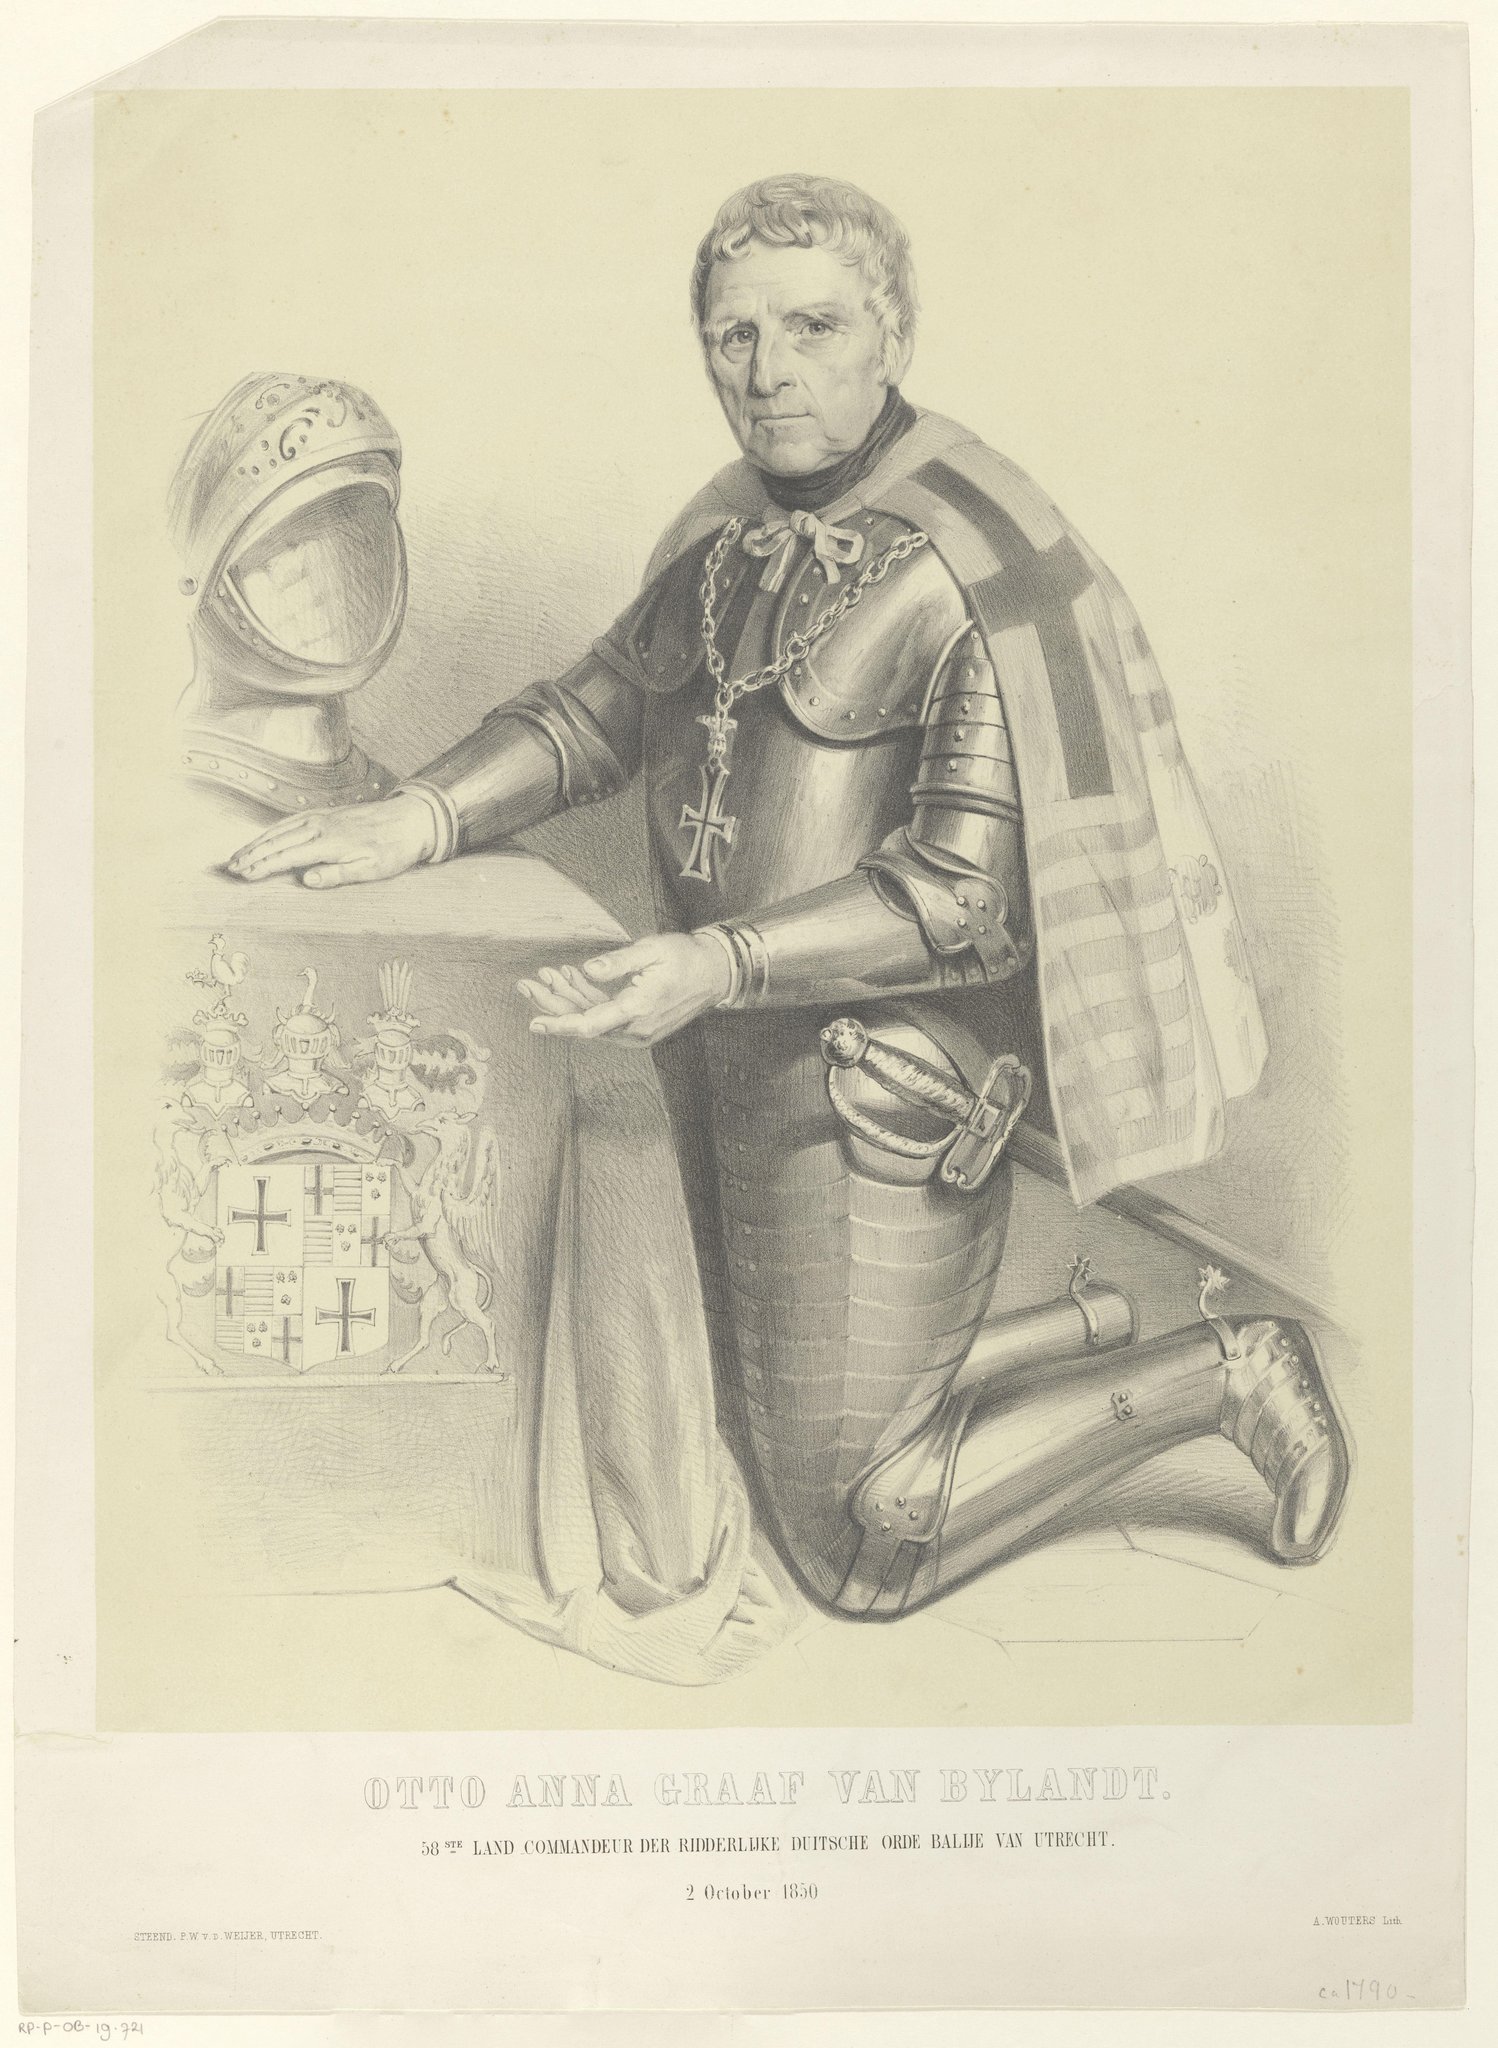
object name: print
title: Portret van Otto Anna van Bylandt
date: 1850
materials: paper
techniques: tone lithography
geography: utrecht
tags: the hague, otto anna van bylandt, helmet, kneeling figure, historical persons (+ full length portrait)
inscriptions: collector's mark: Lugt 2228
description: De geportretteerde draagt een harnas zit knielend voor een tafel. Op het tafelkleed zijn familiewapen. Op tafel zijn helm.